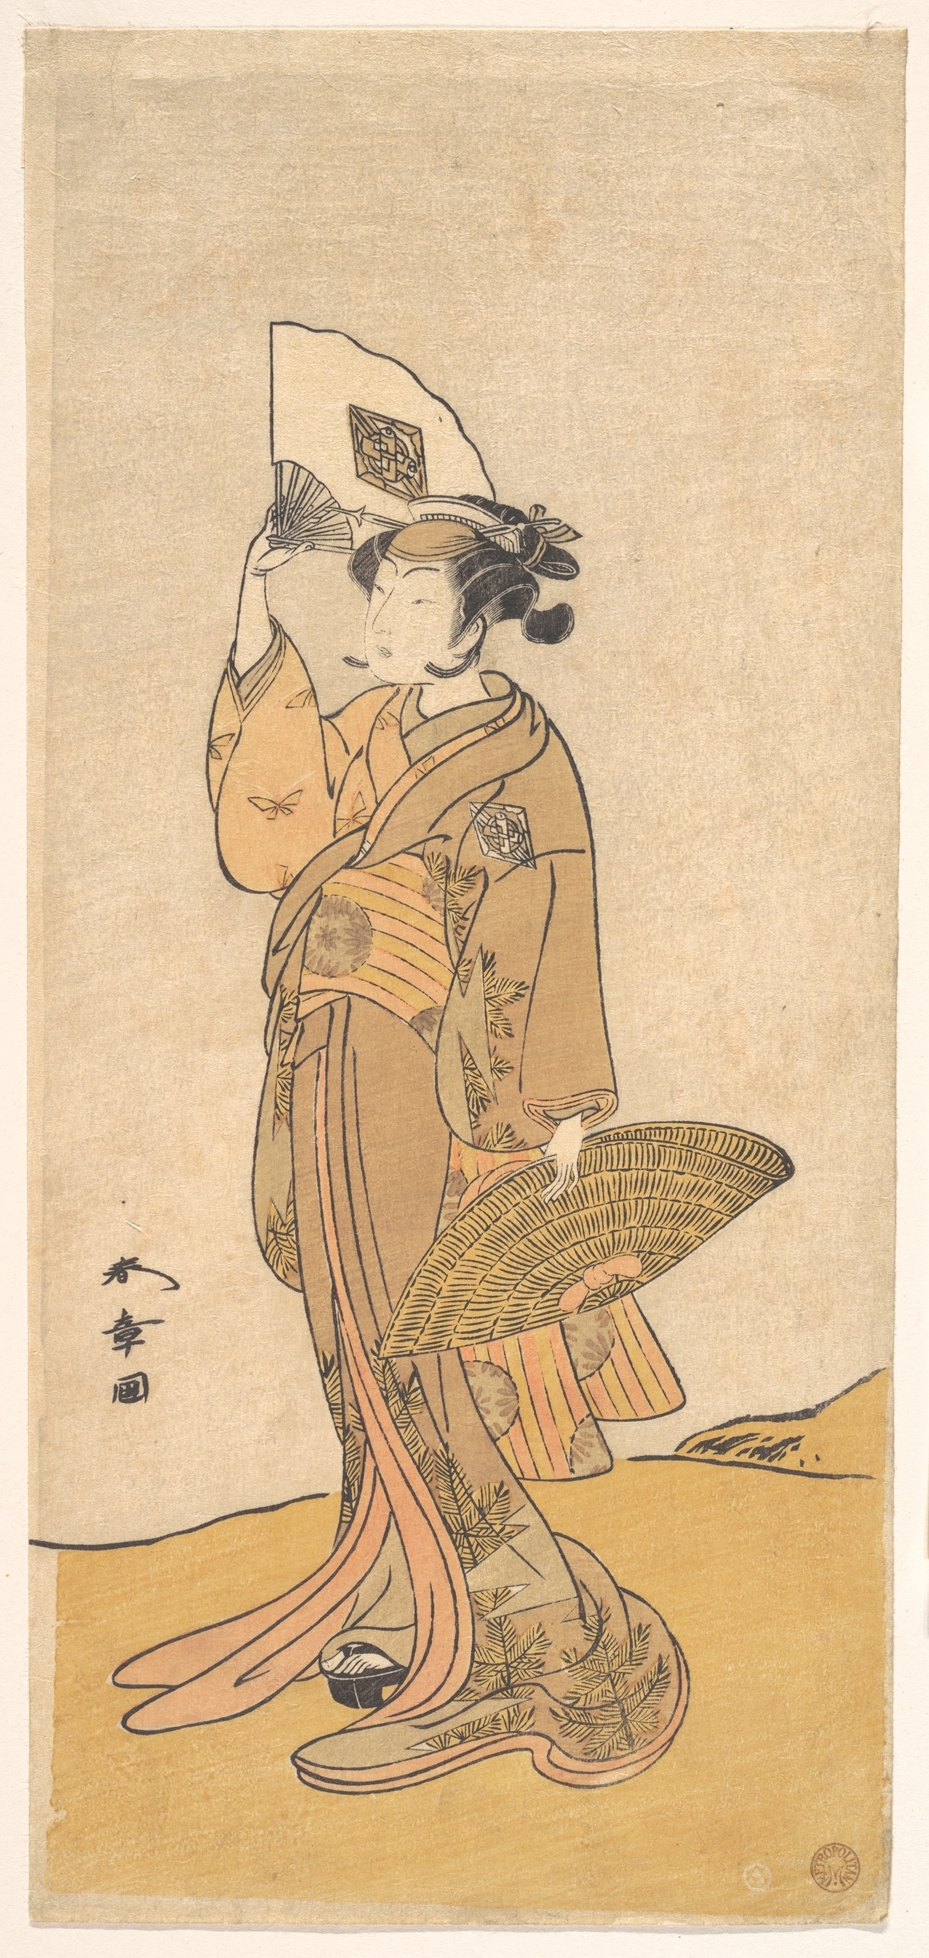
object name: woodblock print nishiki e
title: Kabuki Actor Nakamura Matsue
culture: japanese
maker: katsukawa shunshō 勝川春章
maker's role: artist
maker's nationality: japanese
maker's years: 1726-1792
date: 1772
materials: ink, paper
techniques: nishiki e, woodblock print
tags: fans,actors